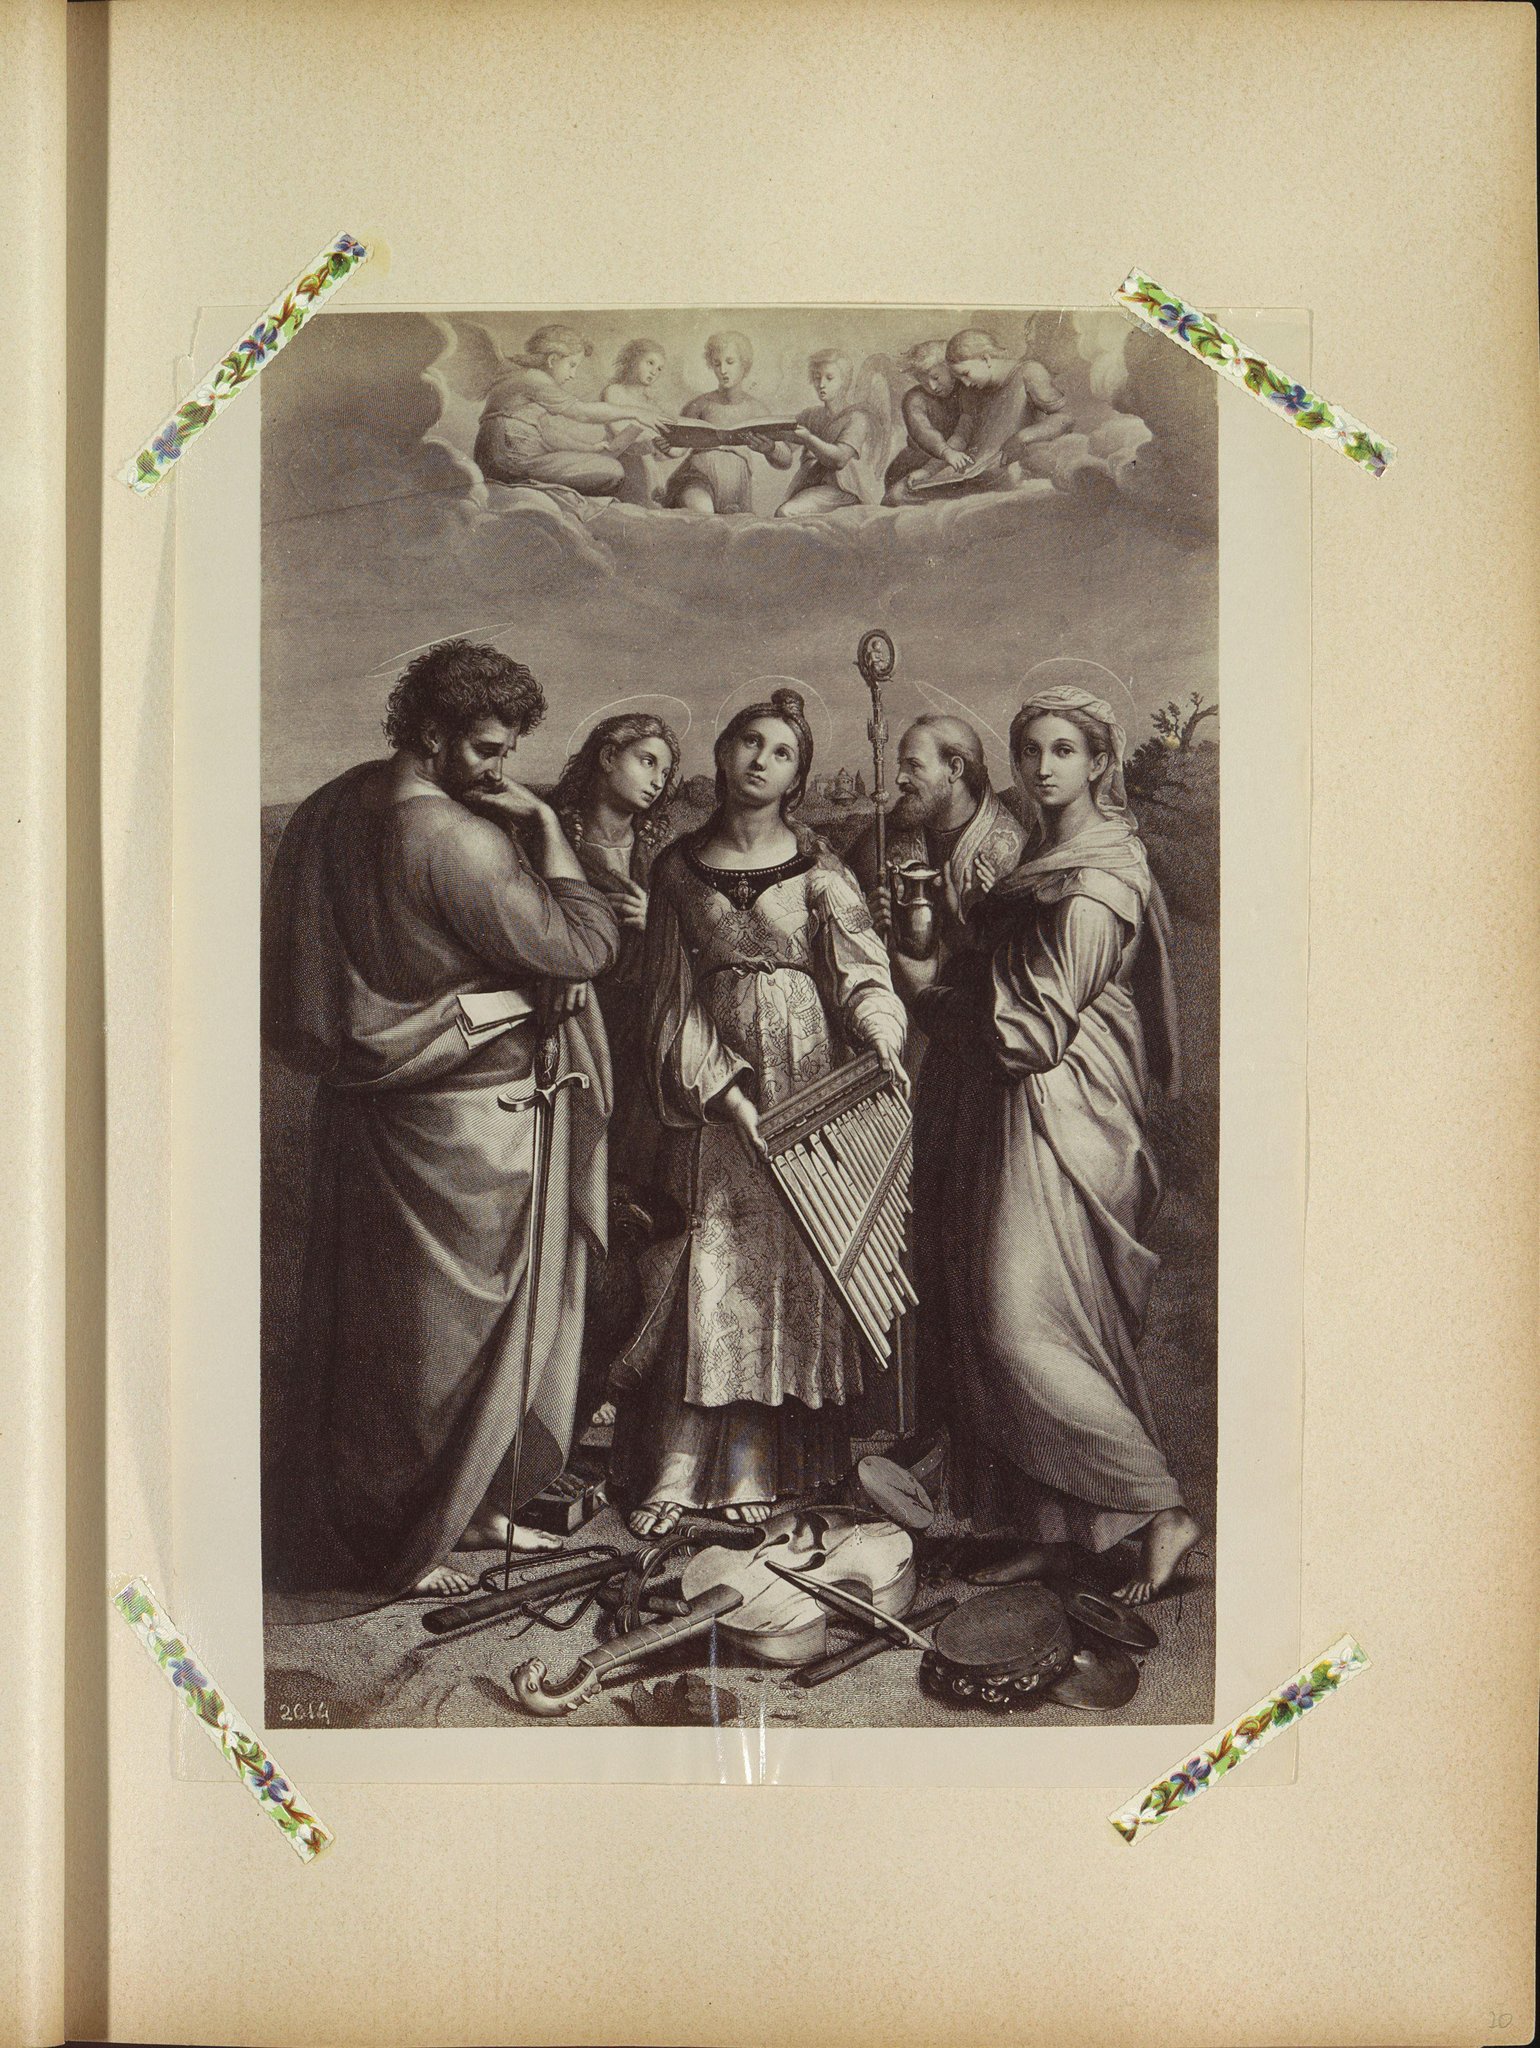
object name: photograph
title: Fotoreproductie van een prent voorstellend de heilige Cecilia in extase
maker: Anonymous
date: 1860-1900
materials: photographic support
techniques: albumen print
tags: st. cecilia as patroness of music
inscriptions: number: ‘2014’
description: Onderdeel van Fotoalbum met opnames van bezienswaardigheden in Italiaanse steden en van kunstwerken.